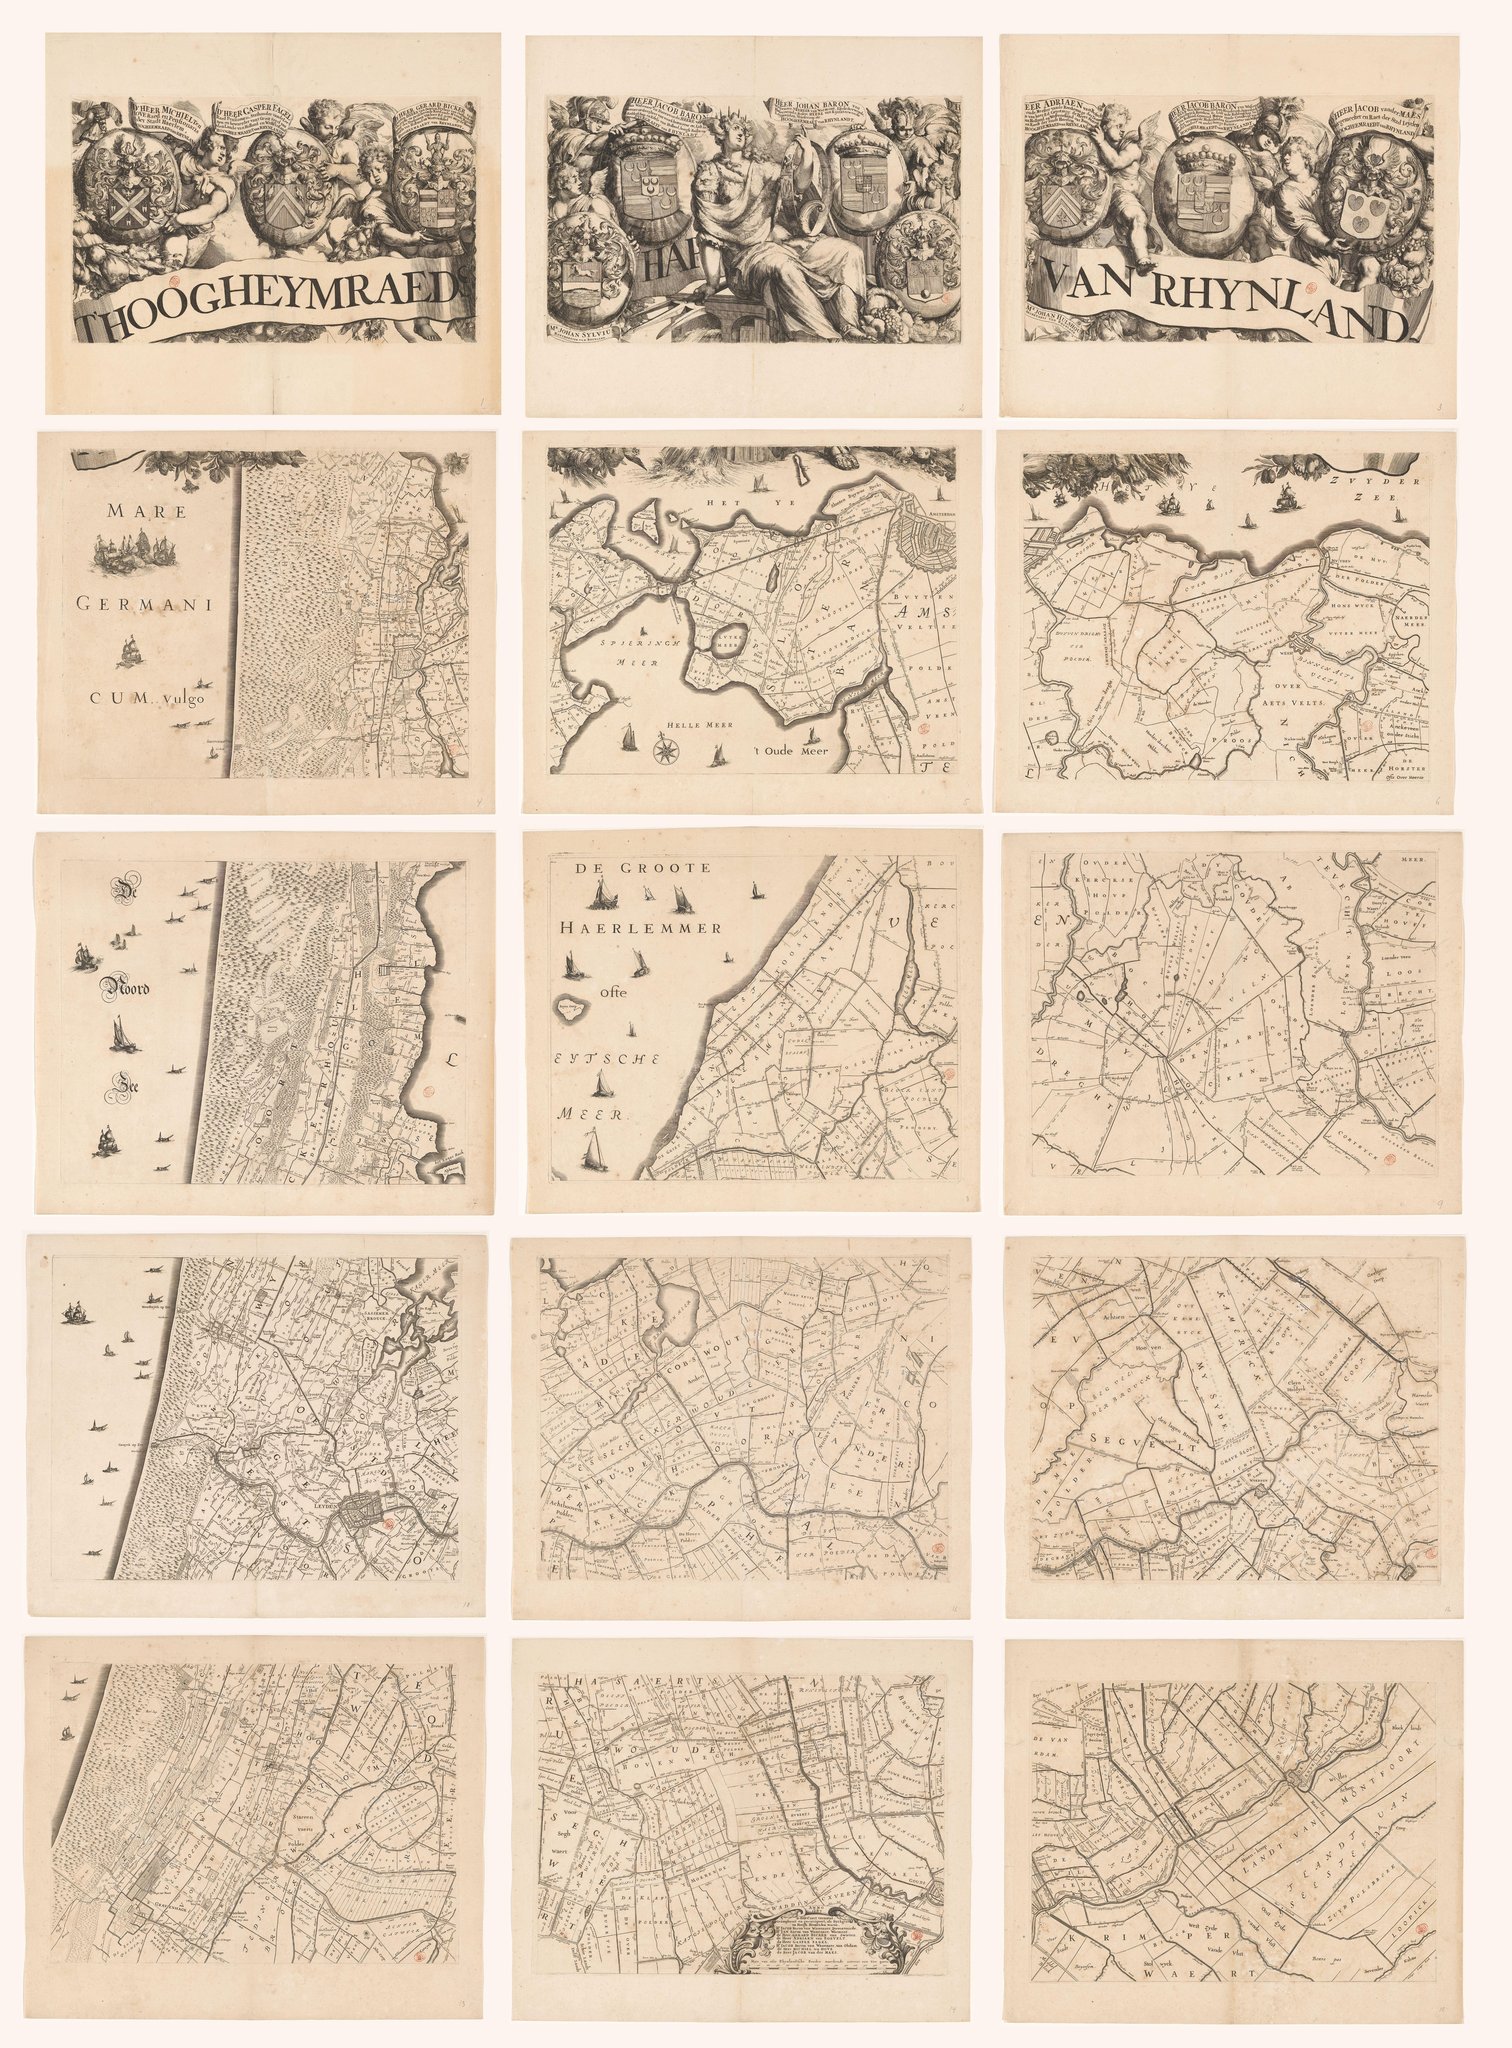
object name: print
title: Kaart van het Hoogheemraadschap van Rijnland, bestaande uit vijftien delen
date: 1647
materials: paper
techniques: engraving, etching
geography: amsterdam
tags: maps of separate countries or regions, polder, reclaimed land, armorial bearing, heraldry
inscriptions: collector's mark: Lugt 195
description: Dit object is omwille van een betere presentatie virtueel samengevoegd maar bestaat fysiek uit losse onderdelen. Dit geheel vormt het kaartdeel en de bovenkant van de sierrand van de tweede druk (1687) van 'T' Hoogheymraedschap van Rhynland', een wandkaart van het Hoogheemraadschap van Rijnland bestaande uit een kaart van het gebied en een sierrand. Van deze kaart zijn voor zover na te gaan drie verschillende drukken bekend, uit respectievelijk 1647, 1687 en 1746. Het kaartdeel is gedrukt van twaalf platen die voor elke druk zijn aangepast. Het vijfde blad van het kaartdeel (RP-P-AO-10-8H) is in of na 1766 nog een keer bijgewerkt en los uitgegeven. Hierdoor zijn van het vijfde blad vier staten bekend en van de overige bladen drie. Zie documentatie voor meer informatie. Bij de eerste en tweede druk hoort een sierrand met daarop de titel, wapenschilden en octrooiverleningen. Delen van de zijkant van de rand van de eerste druk zijn voor de tweede druk herbruikt, terwijl andere delen van de zijkanten en de hele bovenkant nieuw zijn gemaakt door Romeyn de Hooghe. De derde druk heeft slechts een nieuw gemaakte titelstrook langs de bovenkant. Omdat delen van de zijkanten van de sierrand hier ontbreken, is ervoor gekozen alleen het kaartdeel met de bovenkant van de sierrand virtueel samen te voegen. Voor de bij deze druk horende octrooiverleningen, die onderaan langs de linker- en rechterzijkant gemonteerd dienden te worden, zie RP-P-AO-10-7-1 en RP-P-AO-10-7-2. Voor de titelstrook van de derde druk zie RP-P-AO-10-8-A.